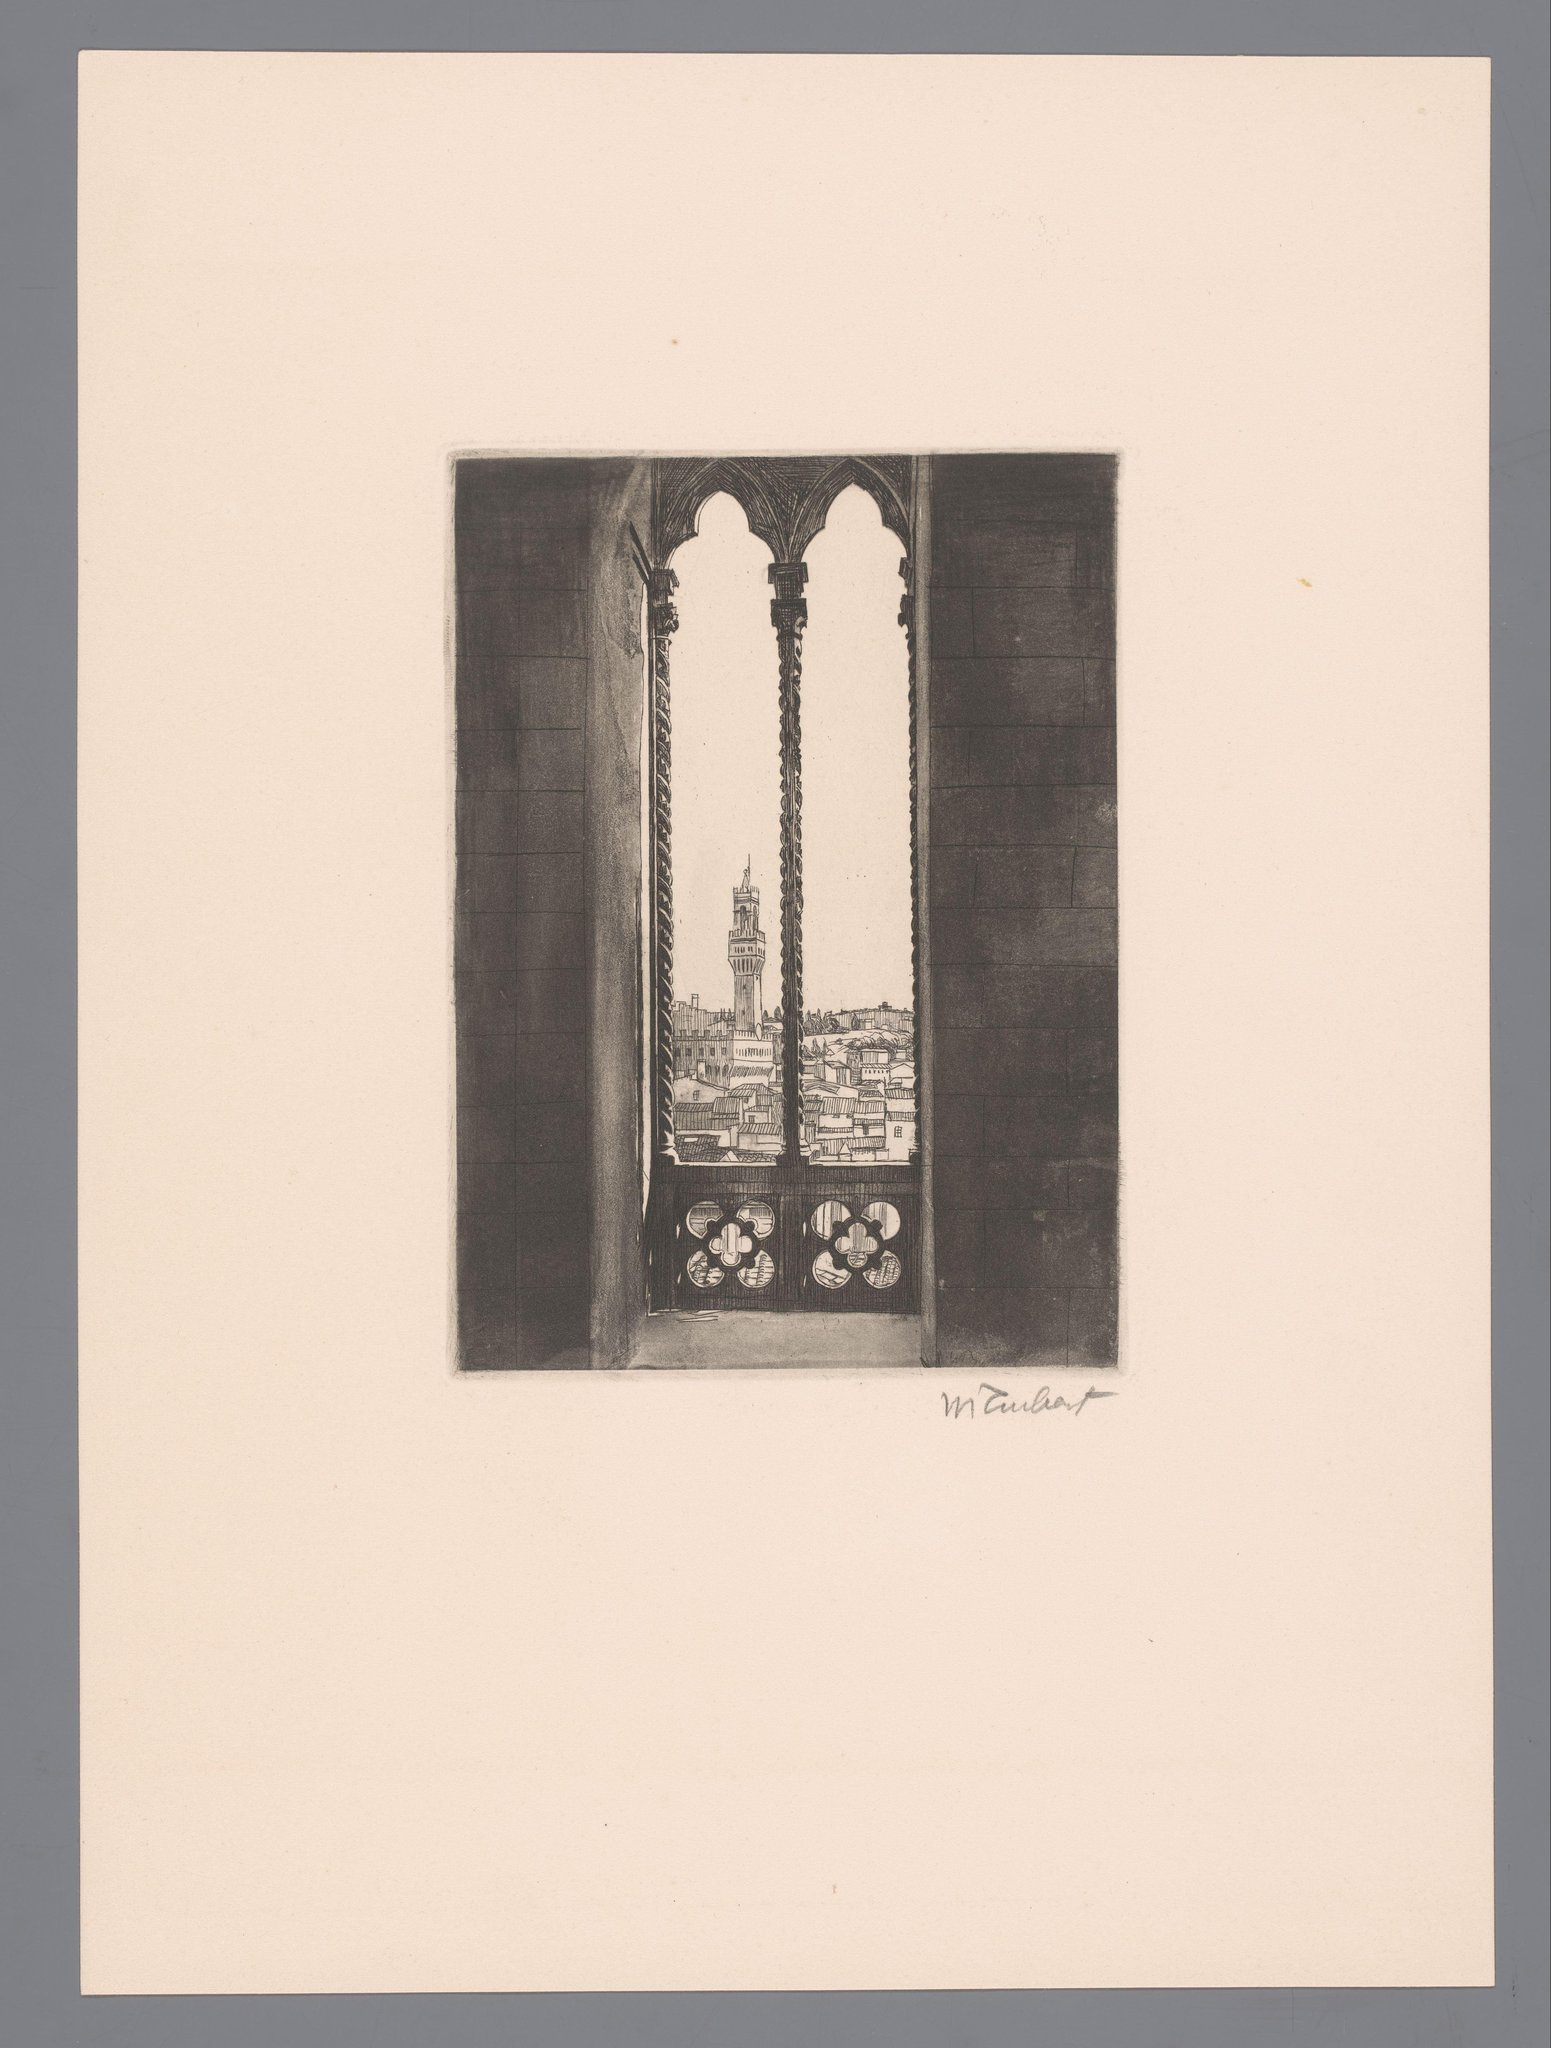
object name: print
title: Gezicht op Florence met het Palazzo Vecchio, mogelijk vanuit Orsanmichele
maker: guglielmo taubert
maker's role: print maker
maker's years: 1876-1949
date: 1886-1927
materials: paper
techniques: aquatint, etching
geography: florence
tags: city-view in general; 'veduta'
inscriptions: collector's mark: Lugt 2228, inscription: ‘M Taubert’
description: Prent maakt deel uit van een serie van tien prenten met gezichten op Florence. De prenten worden bij elkaar bewaard in een omslag met daarop de serietitel en een portret van de prentmaker.